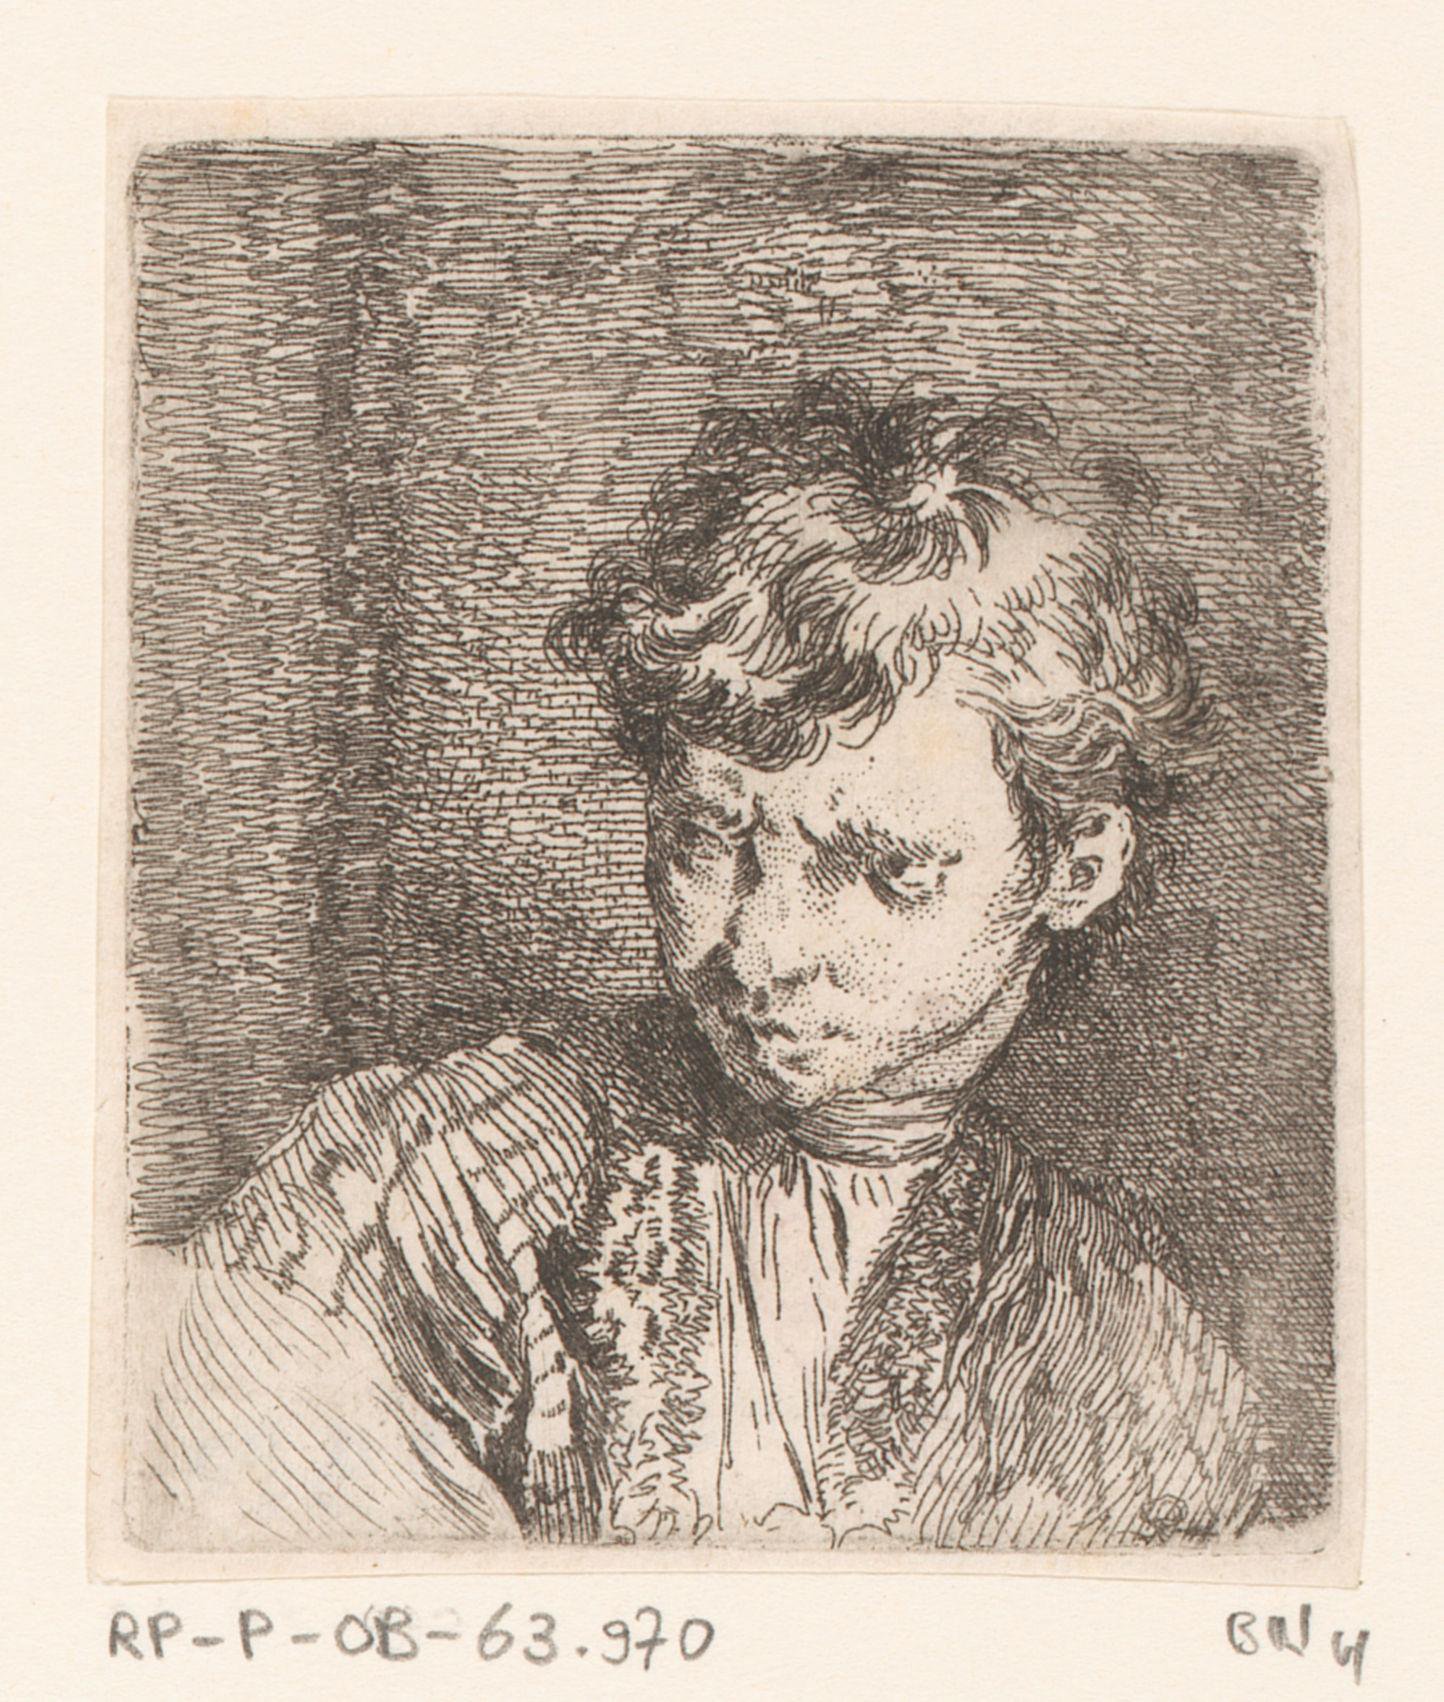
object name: print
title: Recueil de divers griffonnemens et epreuves d'eau forte (...)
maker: jacques-philippe le bas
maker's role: draughtsman, print maker, publisher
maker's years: 1707-1783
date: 1736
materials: paper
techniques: etching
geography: paris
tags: chest, bust, youth, adolescent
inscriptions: collector's mark: Lugt 240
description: Maakt deel uit van een twaalfdelige serie getiteld 'Recueil de divers griffonnemens et epreuves d'eau forte (...)', gegraveerd en uitgegeven door Le Bas te Parijs.